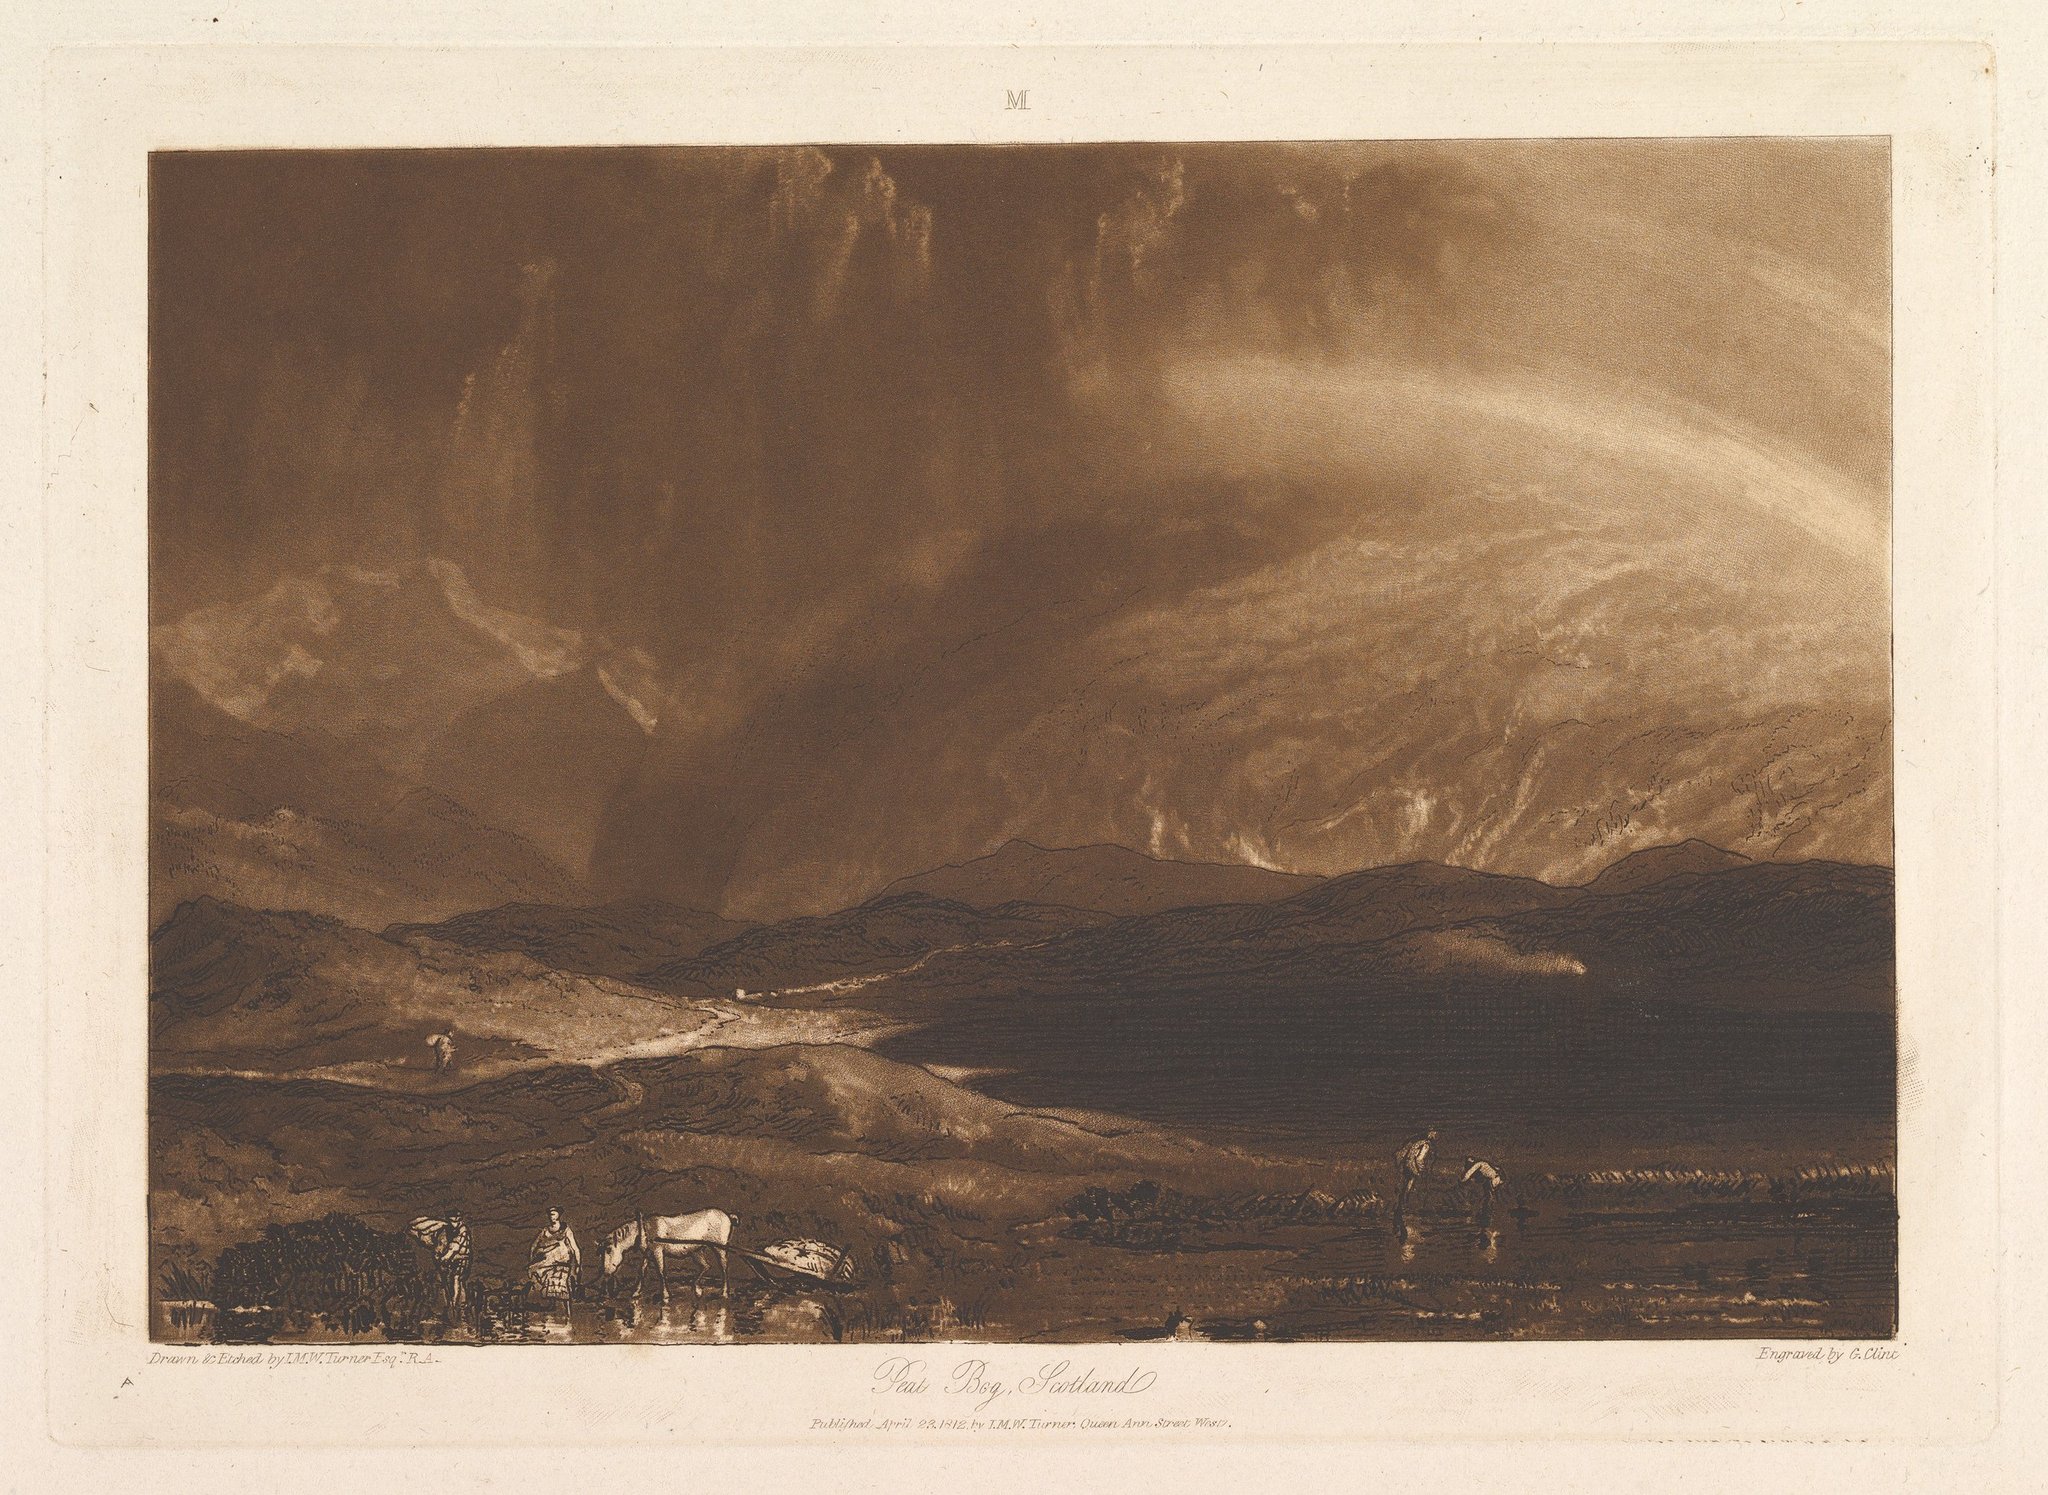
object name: print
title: Peat Bog, Scotland (Liber Studiorum, part IX, plate 45)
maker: joseph mallord william turner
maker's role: artist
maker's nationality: british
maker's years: 1775-1851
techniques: aquatint, etching, mezzotint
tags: landscapes